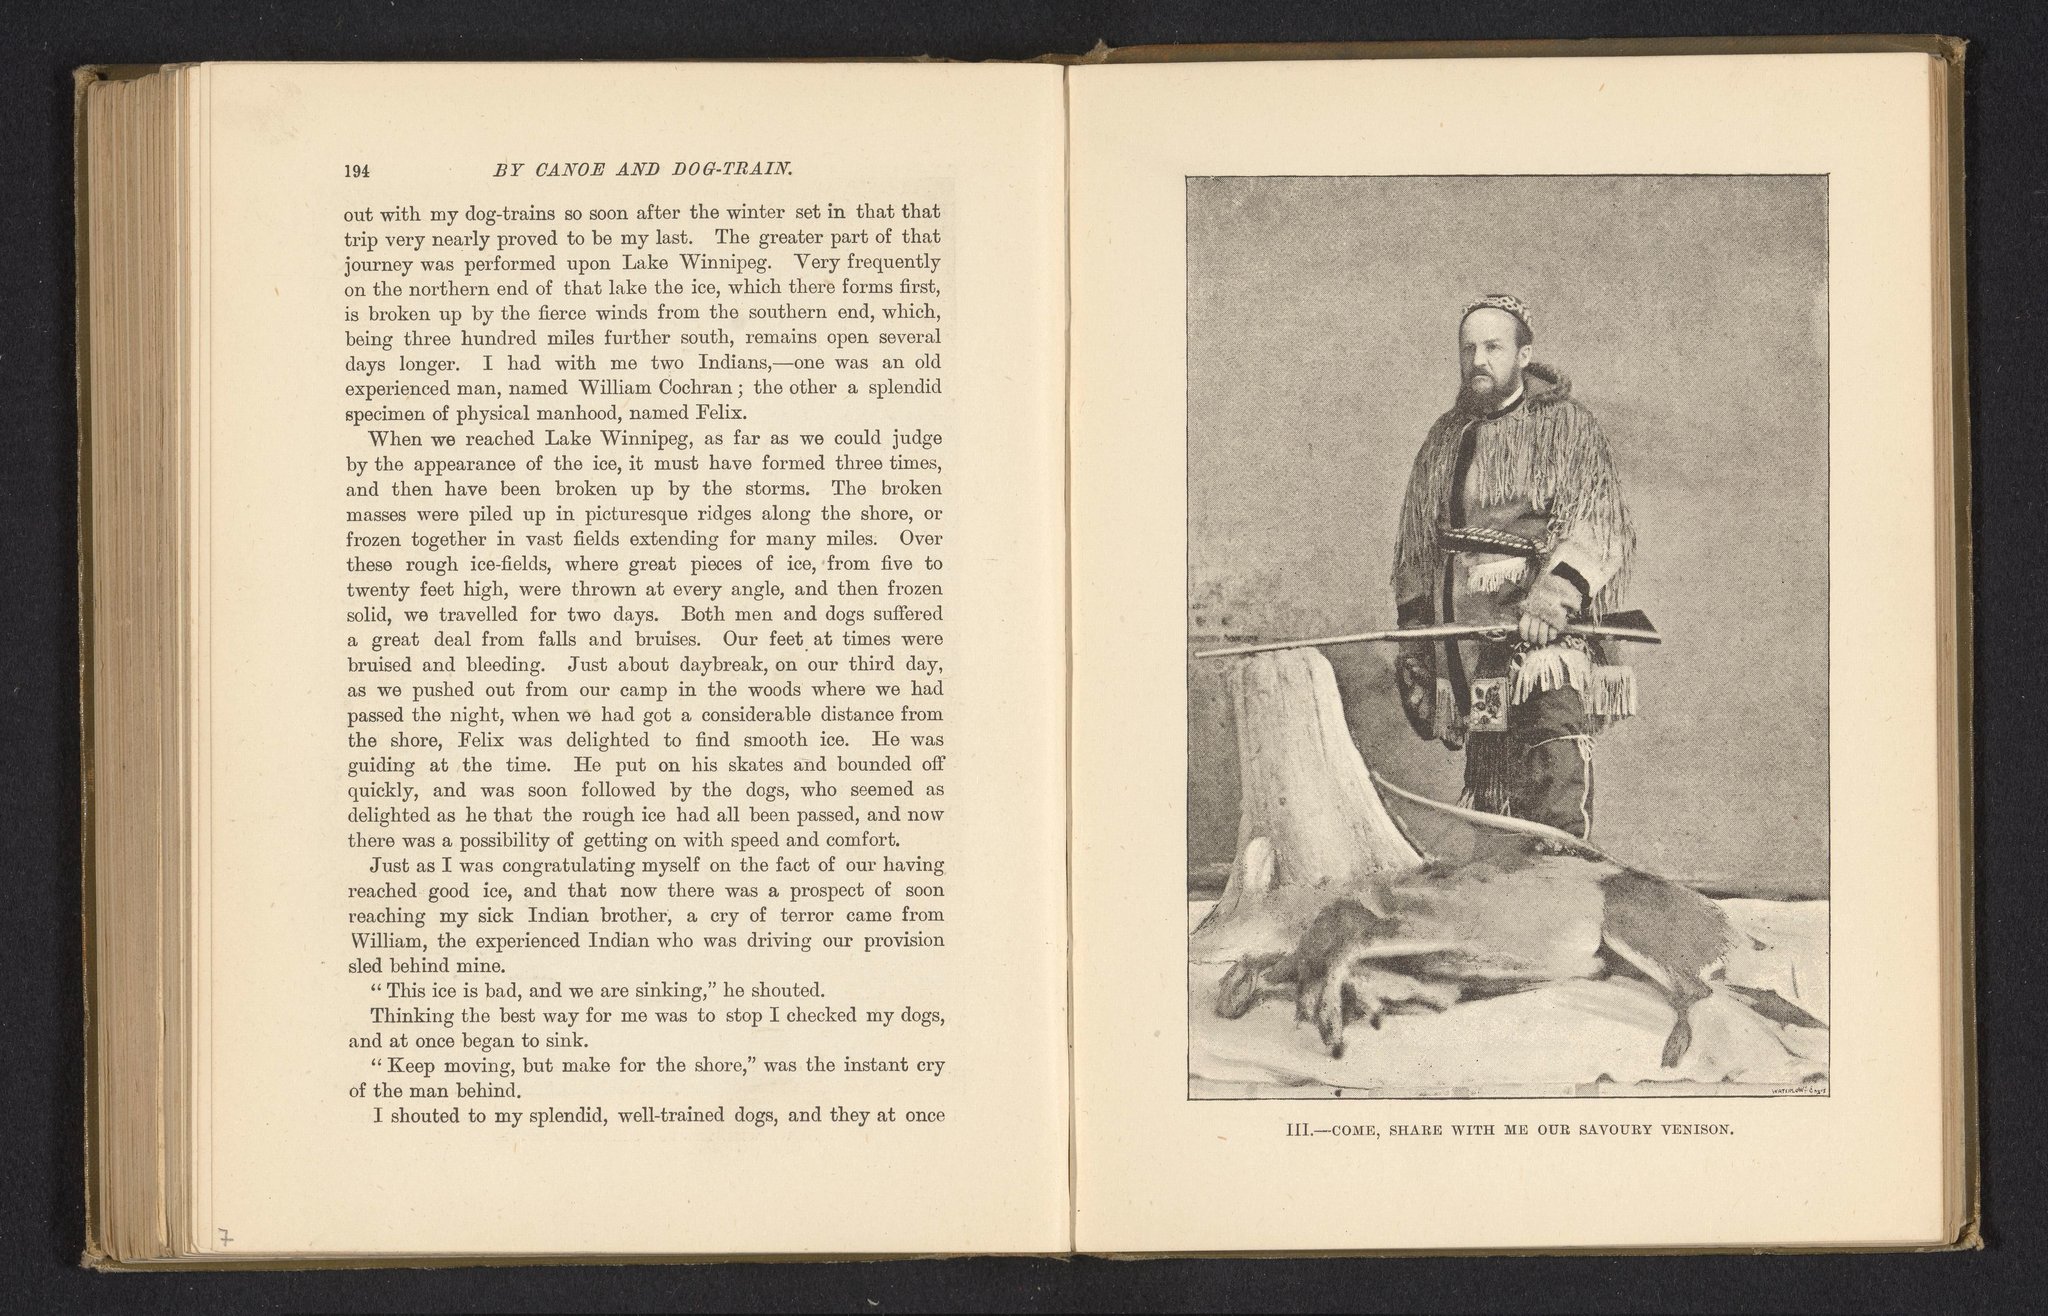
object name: page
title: Portret van vermoedelijk Egerton Ryerson Young als jager, met een geweer en zijn voet op een prooi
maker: Anonymous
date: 1882-1892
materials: paper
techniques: autotype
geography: canada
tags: missionary, egerton ryerson young, hunter, game, hunted animals, firearms